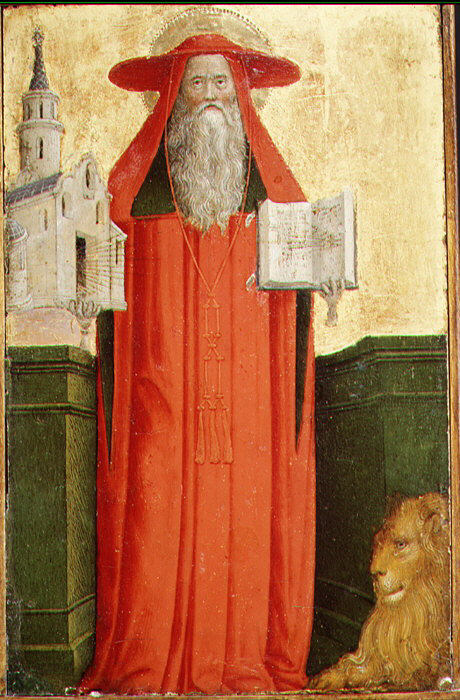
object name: painting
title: Saint Jerome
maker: antonio vivarini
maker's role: artist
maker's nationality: italian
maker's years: 1440-1484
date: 1440-1449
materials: gold leaf, paint, wood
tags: saint jerome